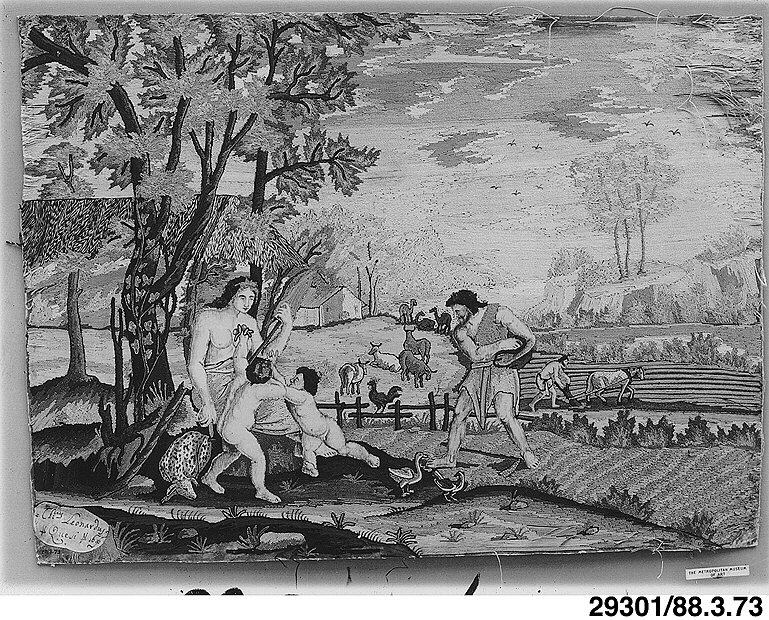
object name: embroidered picture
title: Rural scene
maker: leonardus quesi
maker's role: maker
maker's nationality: french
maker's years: 1650-1750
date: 1696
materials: cardboard, silk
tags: men,women,agriculture